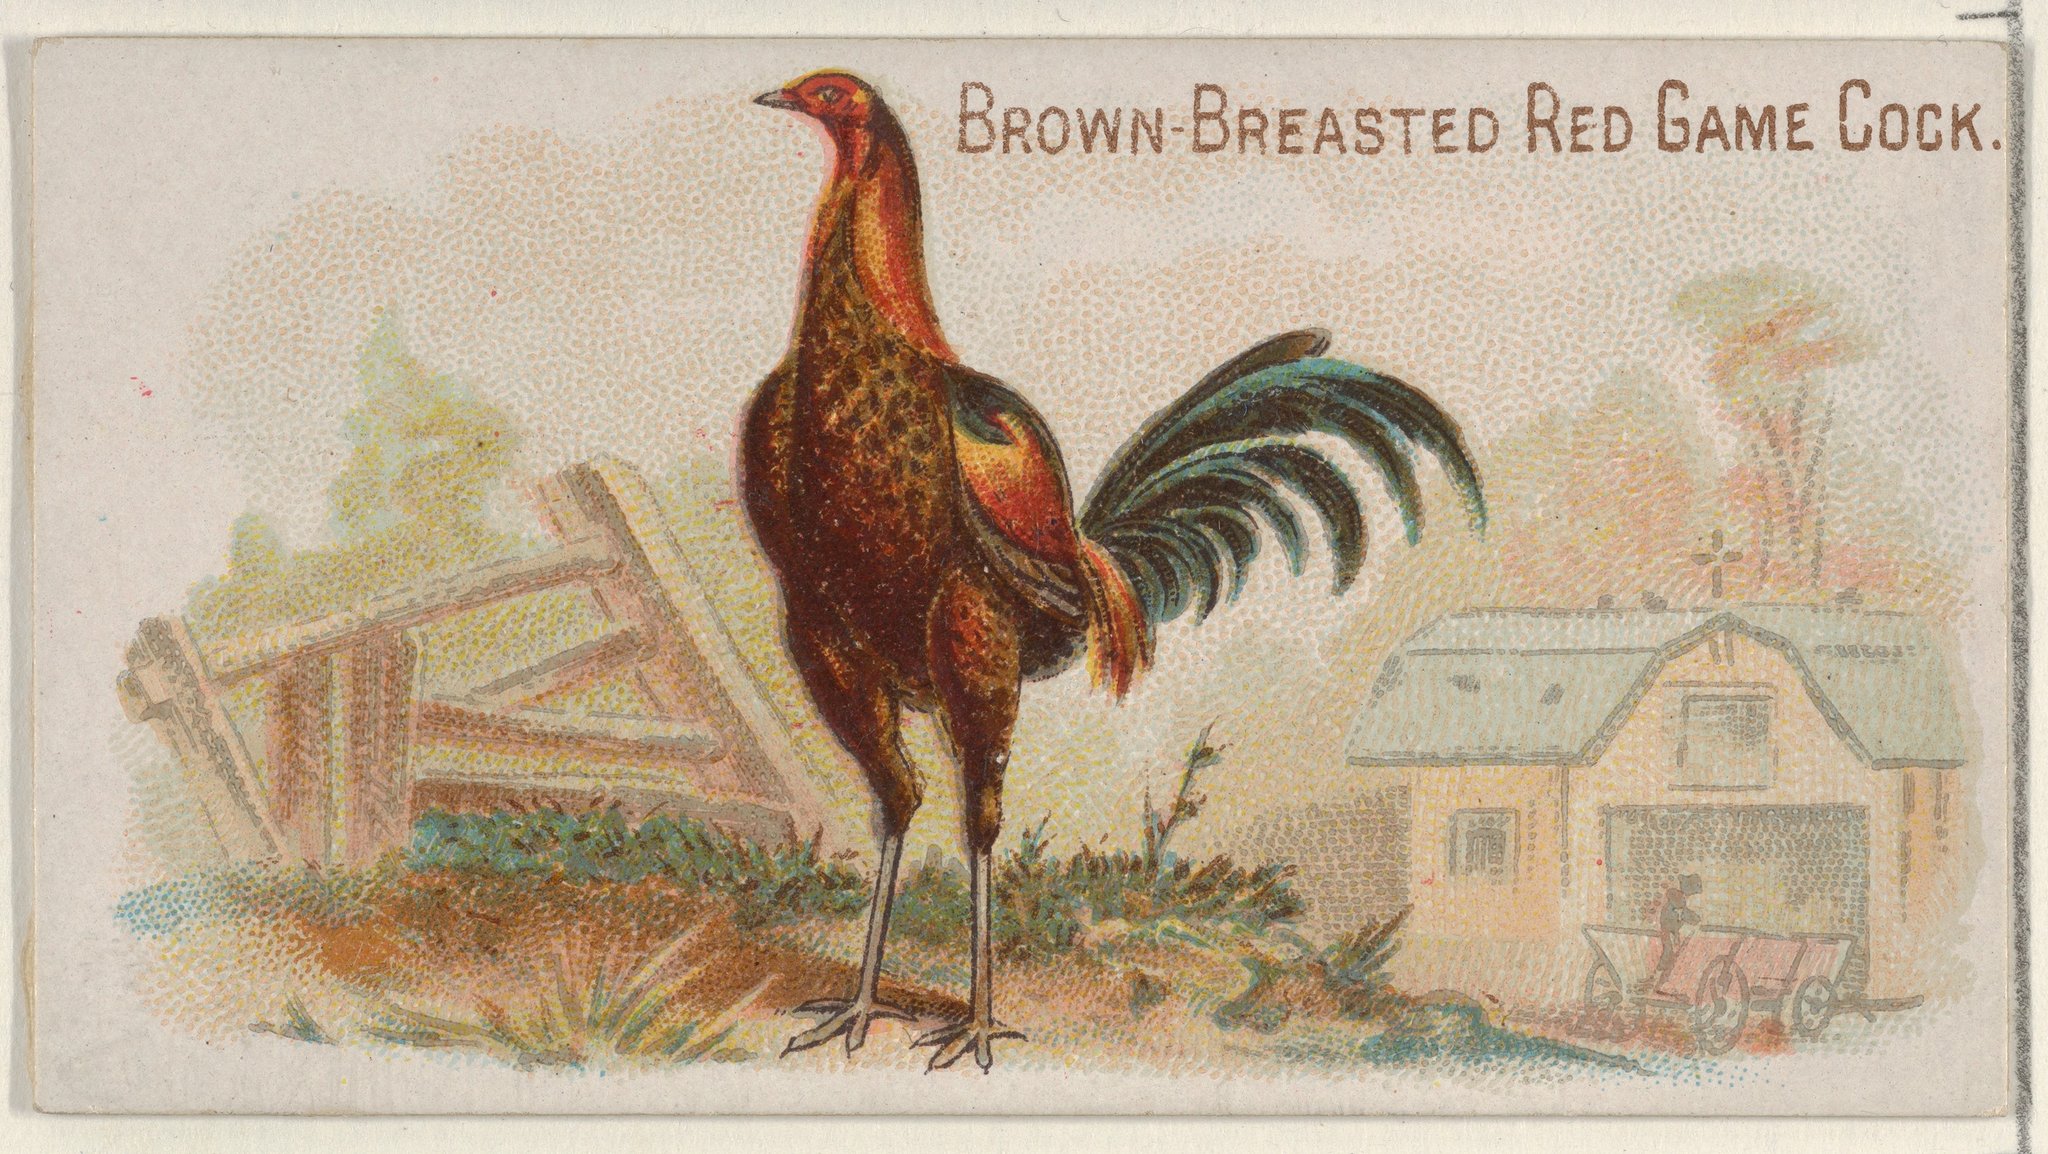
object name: print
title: Brown-Breasted Red Game Cock, from the Prize and Game Chickens series (N20) for Allen & Ginter Cigarettes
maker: allen & ginter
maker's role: publisher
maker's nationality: american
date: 1891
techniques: color lithograph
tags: roosters